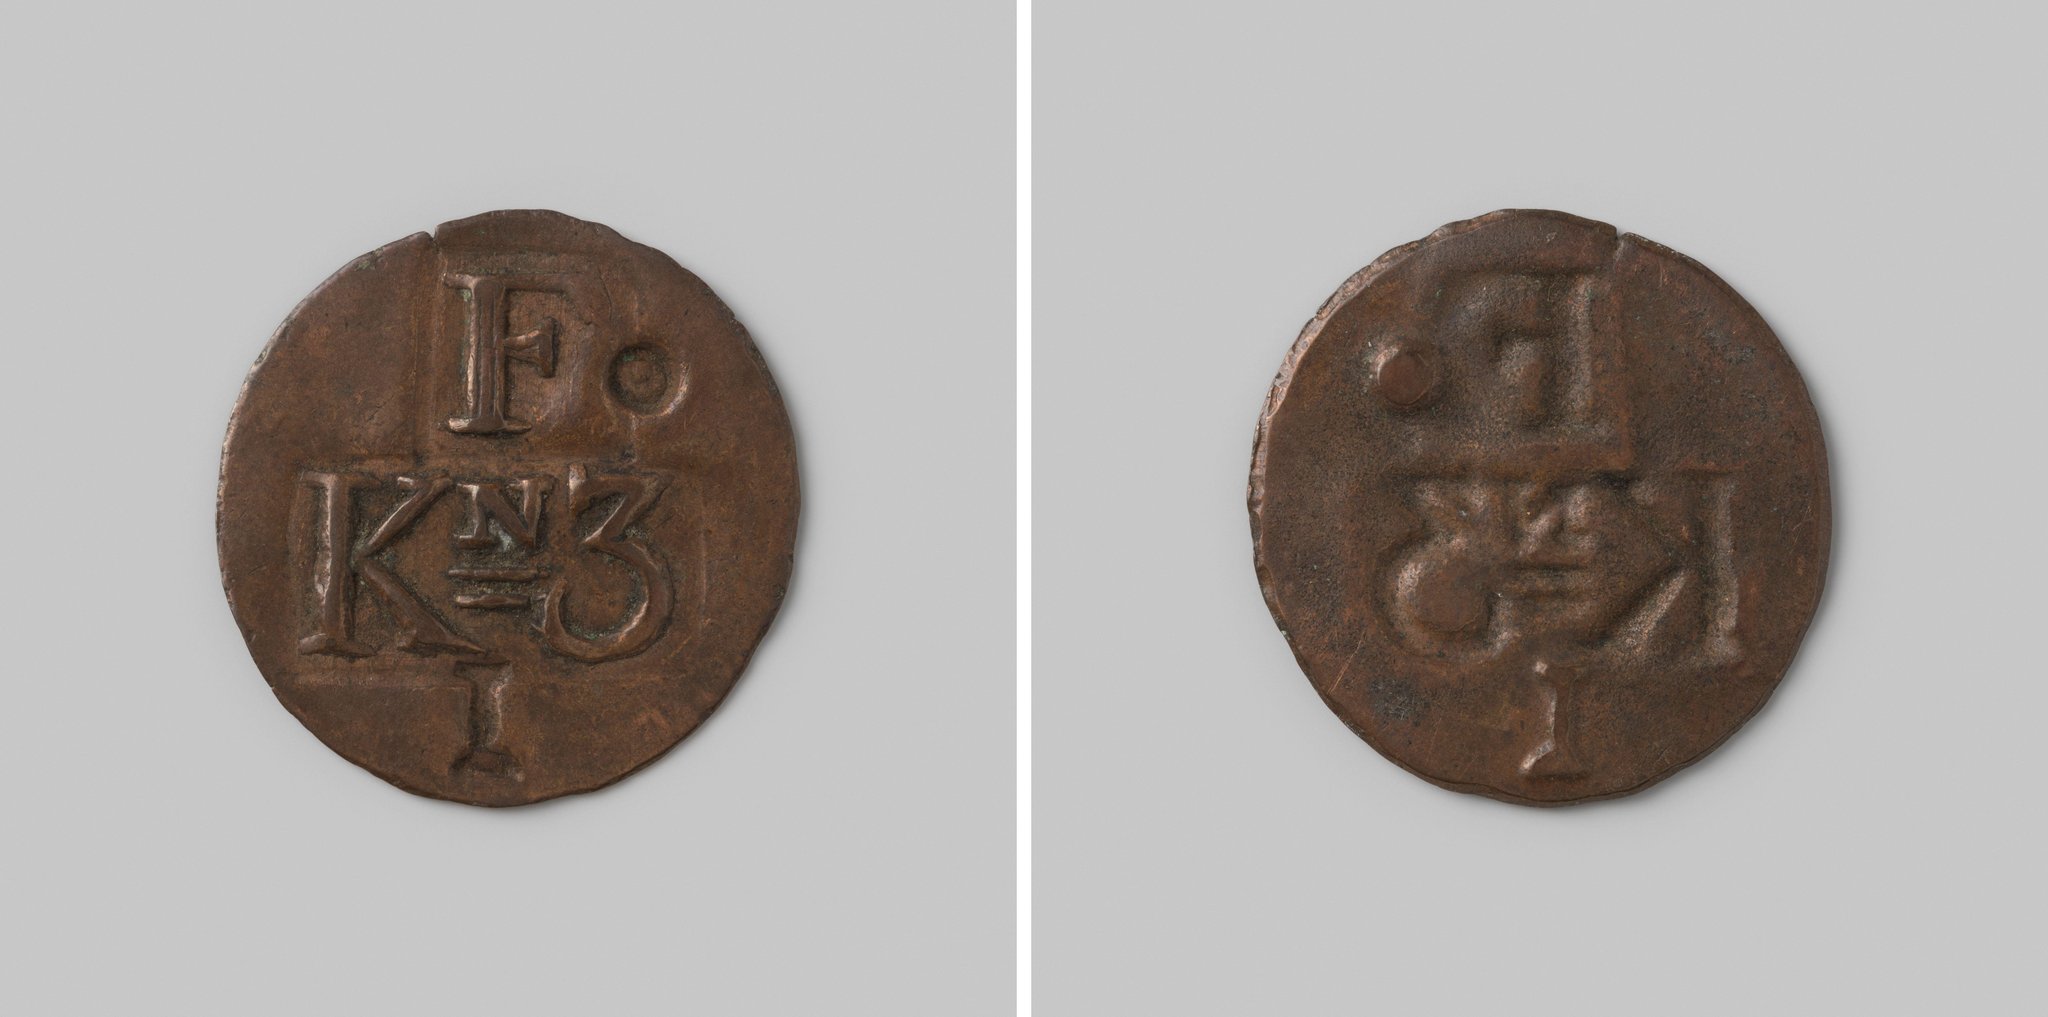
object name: monetary token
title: Derde gesticht van de Veenkolonie Frederiksoord, huismunt geslagen op last van de Maatschappij van Weldadigheid ter waarde van 1 cent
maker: Anonymous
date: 1825-1830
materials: copper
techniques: printing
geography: netherlands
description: Rond koperen plaatje met vier instempelingen: F - (stip) / Kn3 / I